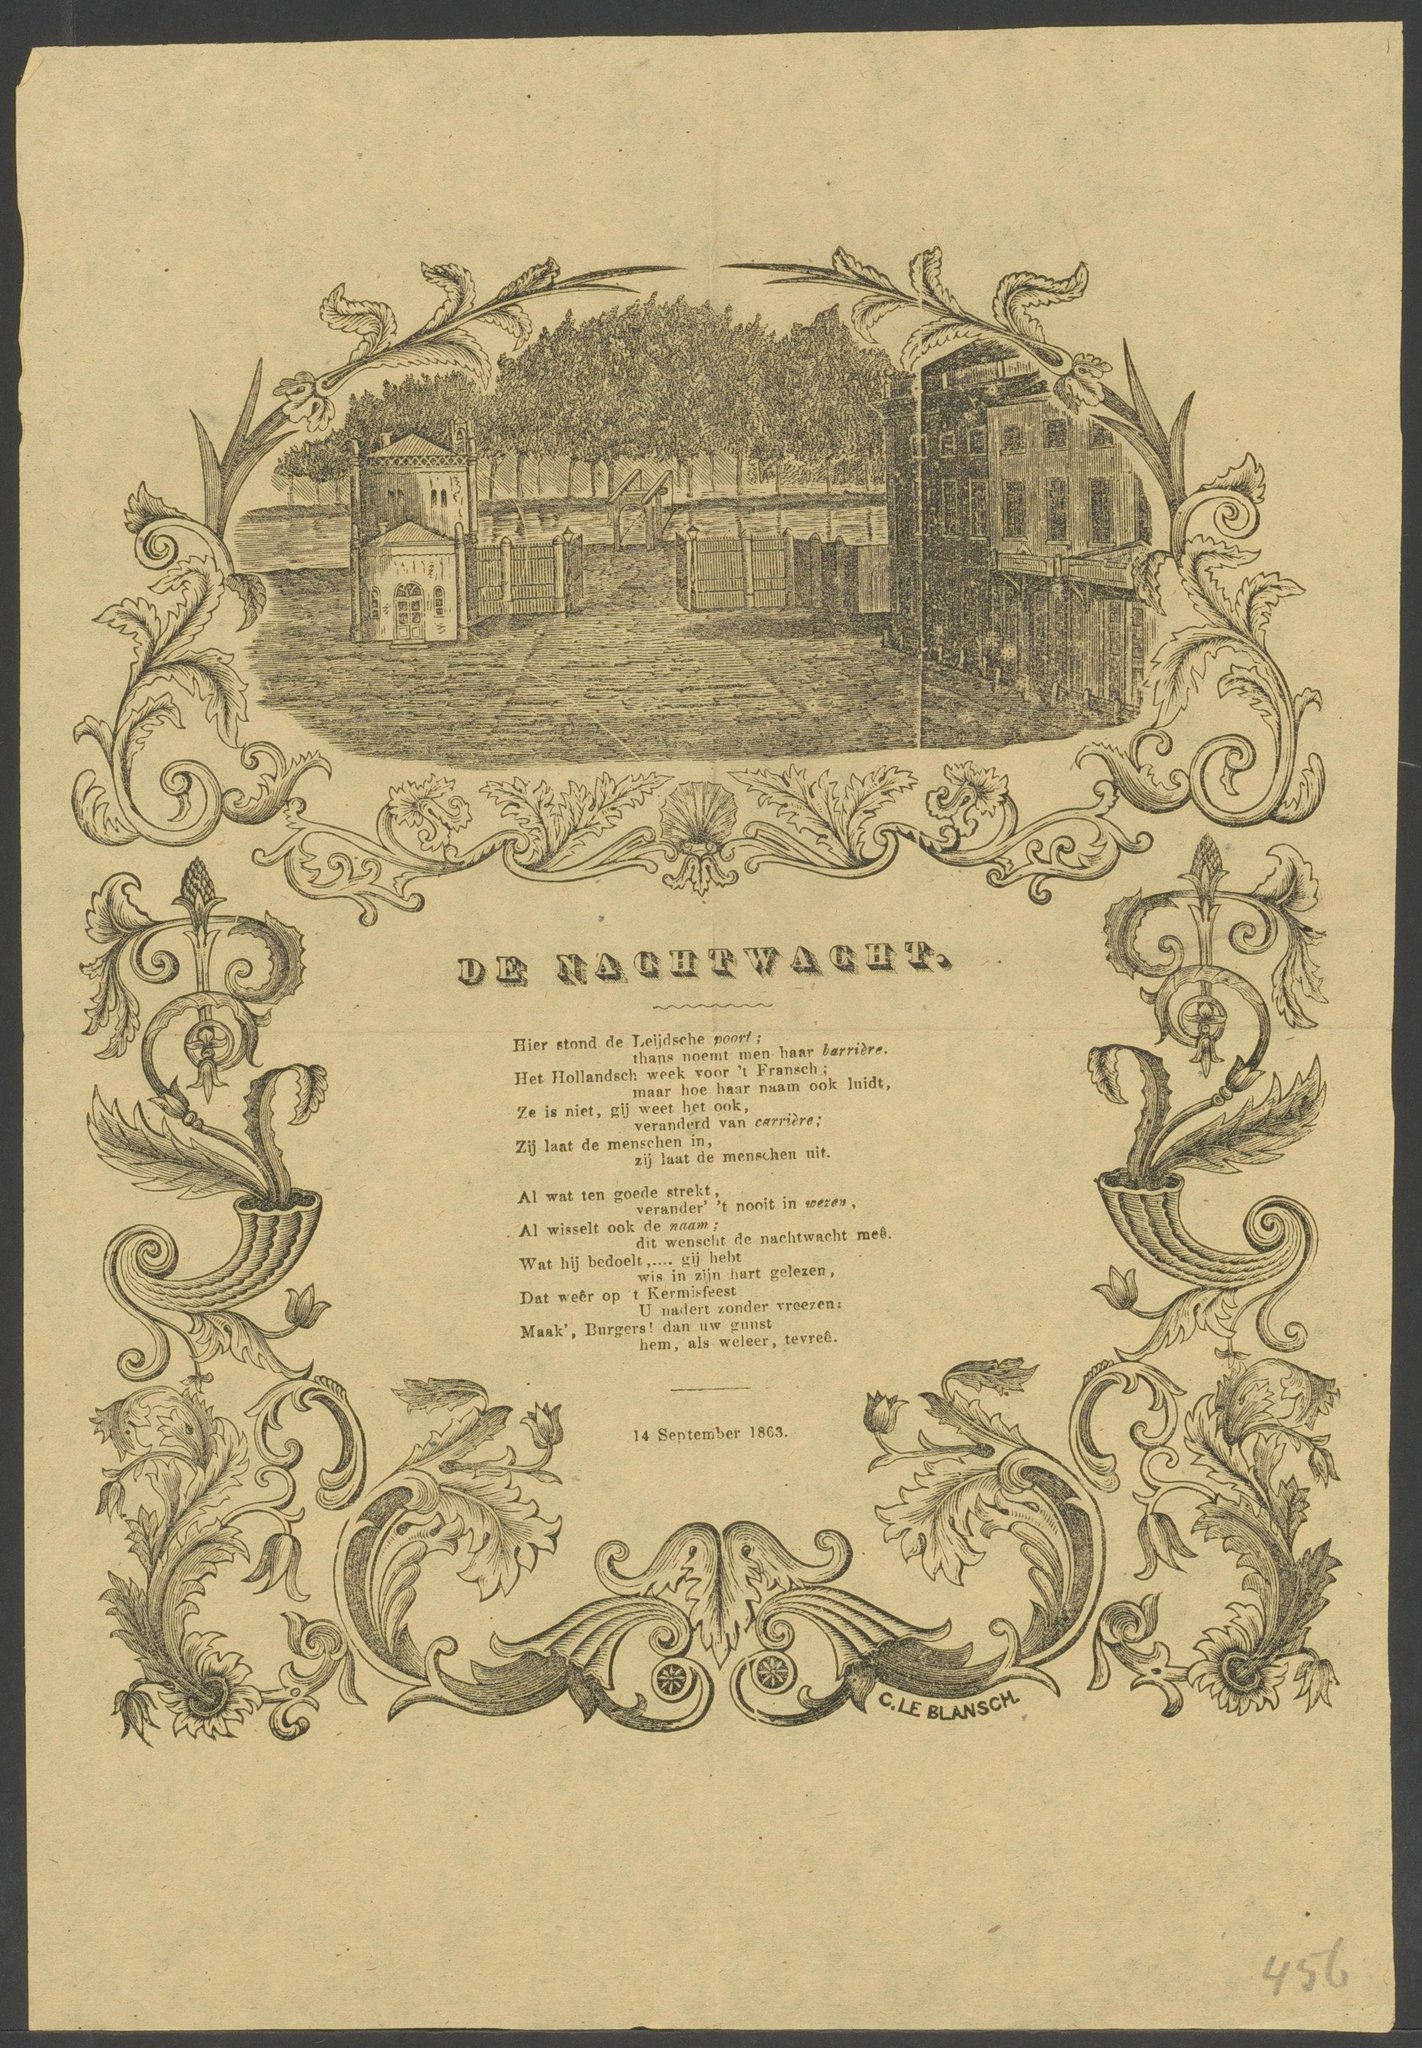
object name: fair print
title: De nachtwacht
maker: christiaan le blansch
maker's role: print maker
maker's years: 1827-1886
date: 1863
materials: paper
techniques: letterpress printing, engraving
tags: night patrol, pleasure fair and circus, amsterdam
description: Kermisprent van de Amsterdamse nachtwacht (ratelwacht), 14 september 1863. Centraal een gedicht, daarboven de plaats van de voormalige Leidse Poort te Amsterdam. Onderwerpsrubrieken binnen de Atlas Zeden en Gewoonten: Zeden en gewoonten in engeren zin, Volksleven, Volksbladen, Nieuwjaars- en Kerstwenschen, Amsterdam.